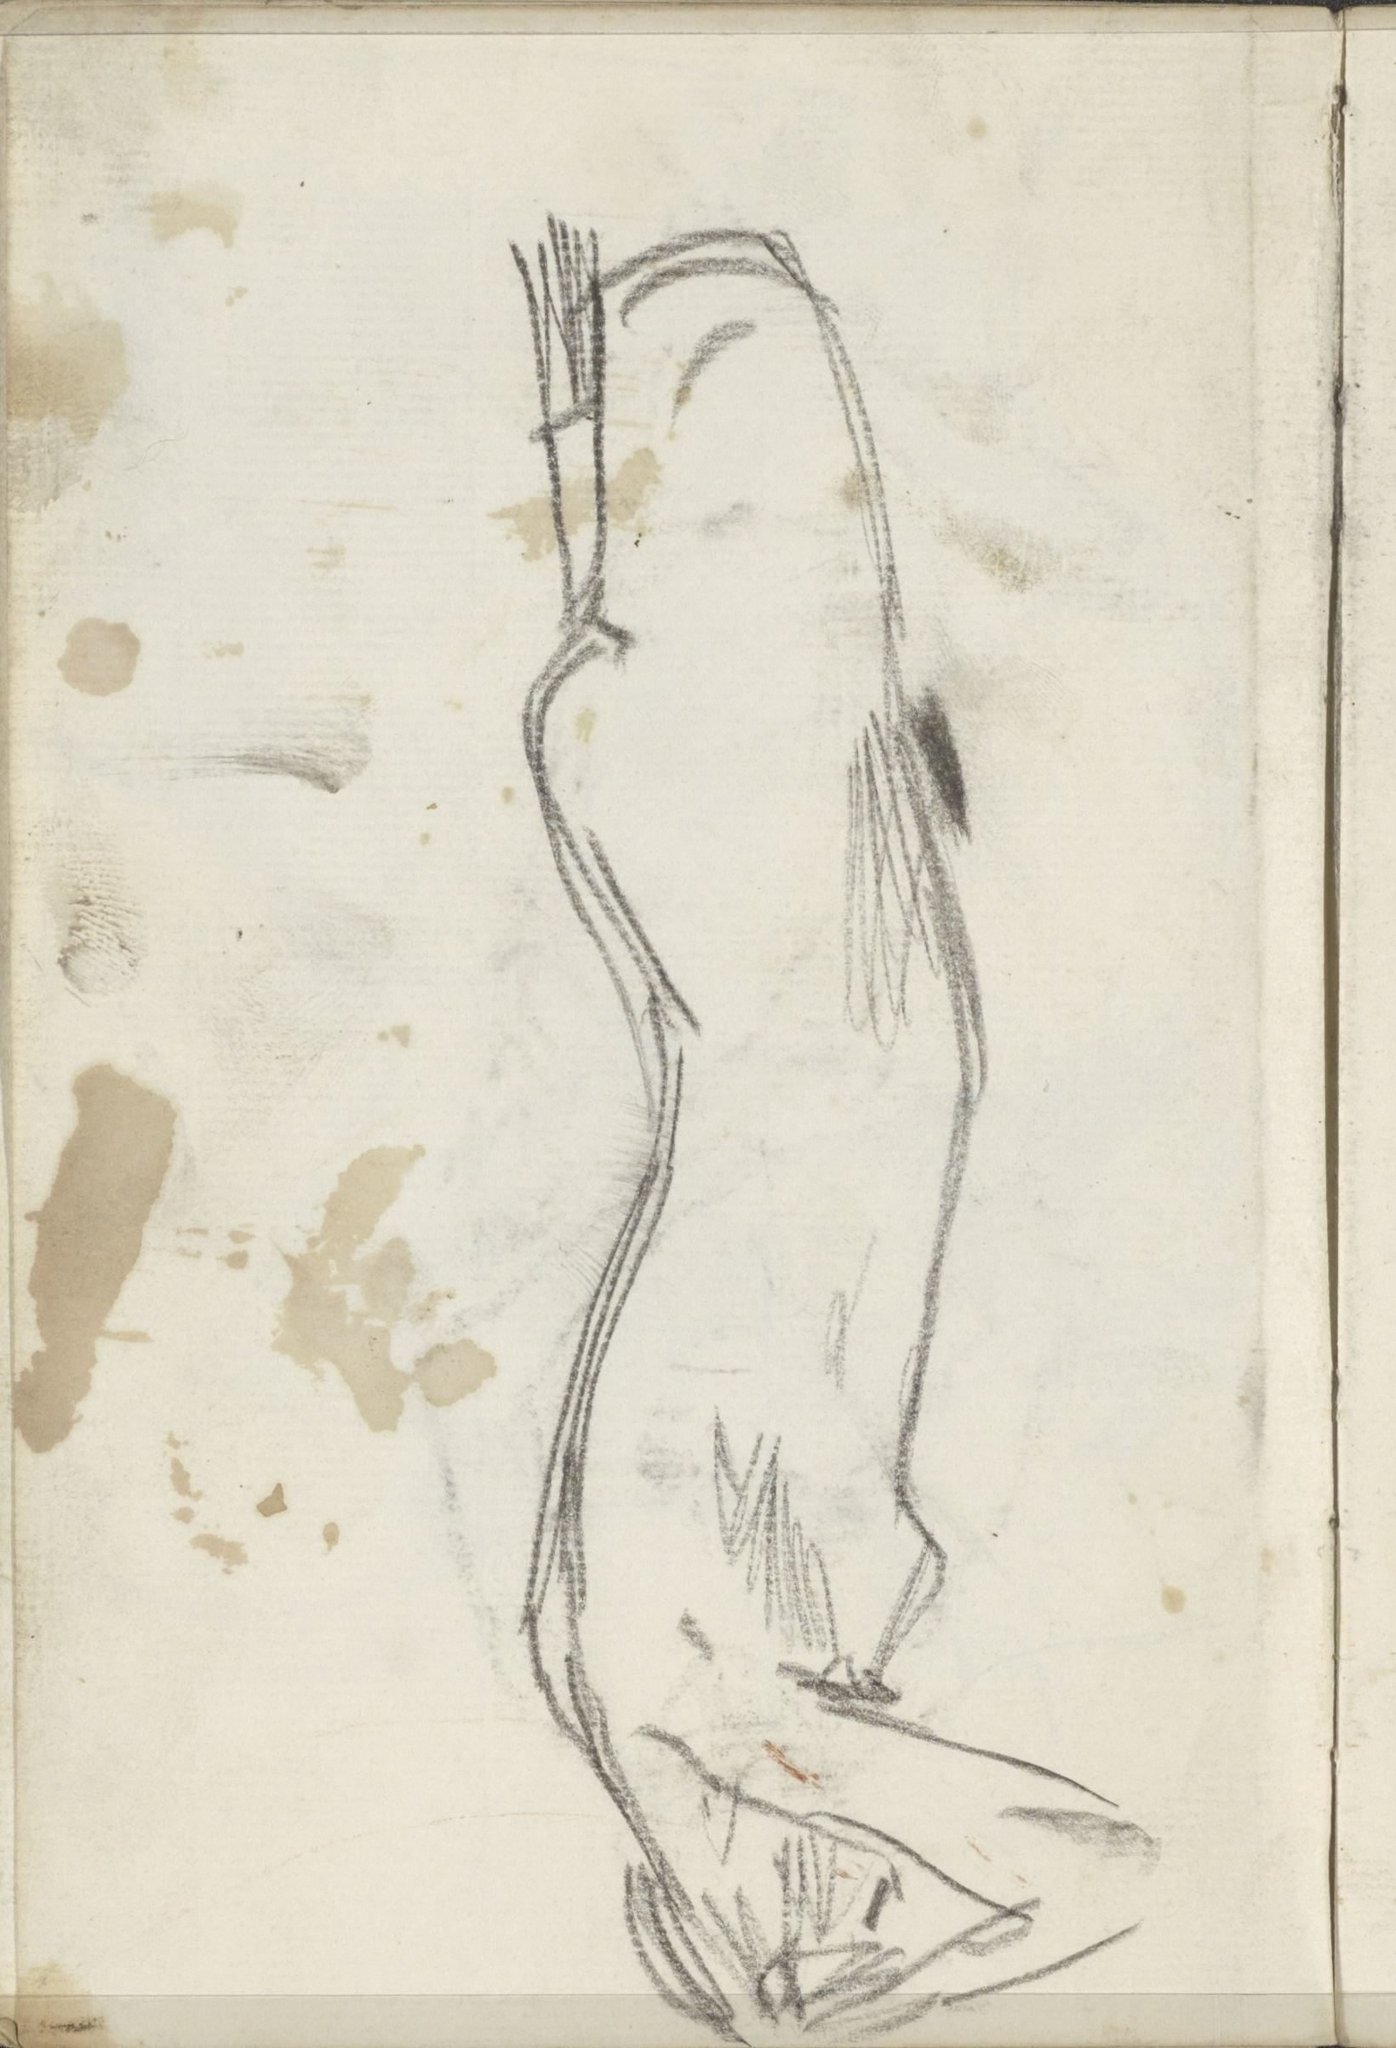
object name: sketchbook leaf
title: Staand vrouwelijk naakt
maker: george hendrik breitner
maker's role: draughtsman, painter, print maker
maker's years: 1857-1923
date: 1886-1898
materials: chalk, paper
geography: amsterdam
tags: the (nude) human figure; 'corpo humano' (ripa) - aa - female human figure (+ standing)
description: Pagina 23 uit een schetsboek met 21 bladen.